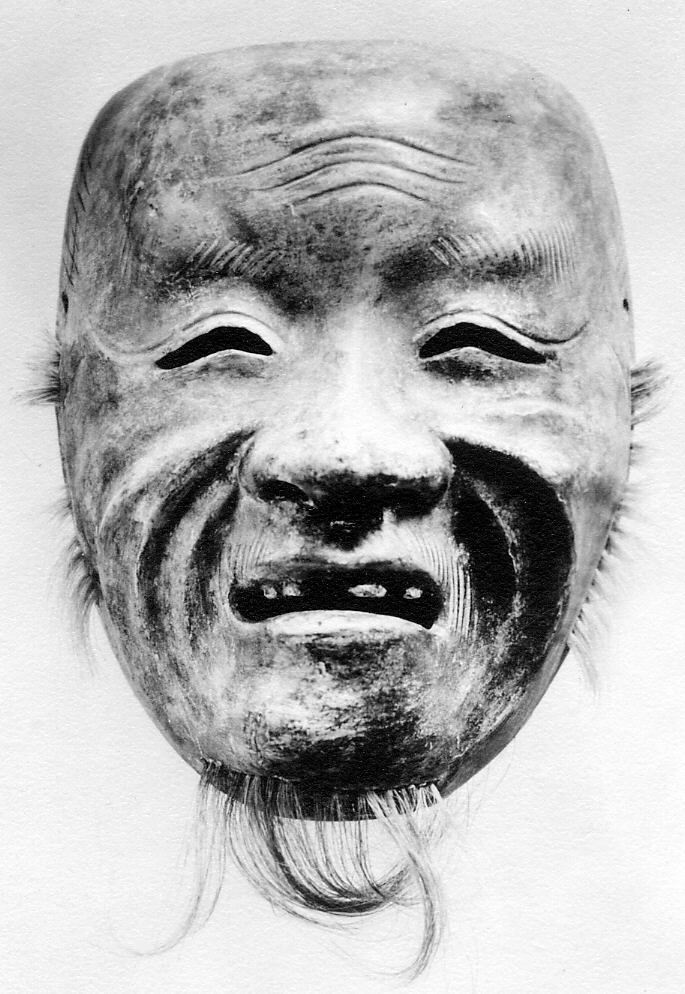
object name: kyogen mask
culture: japanese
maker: tenkaichi taiko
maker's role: artist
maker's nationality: japanese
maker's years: 1516-1616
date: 1601-1633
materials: wood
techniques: lacquer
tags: masks